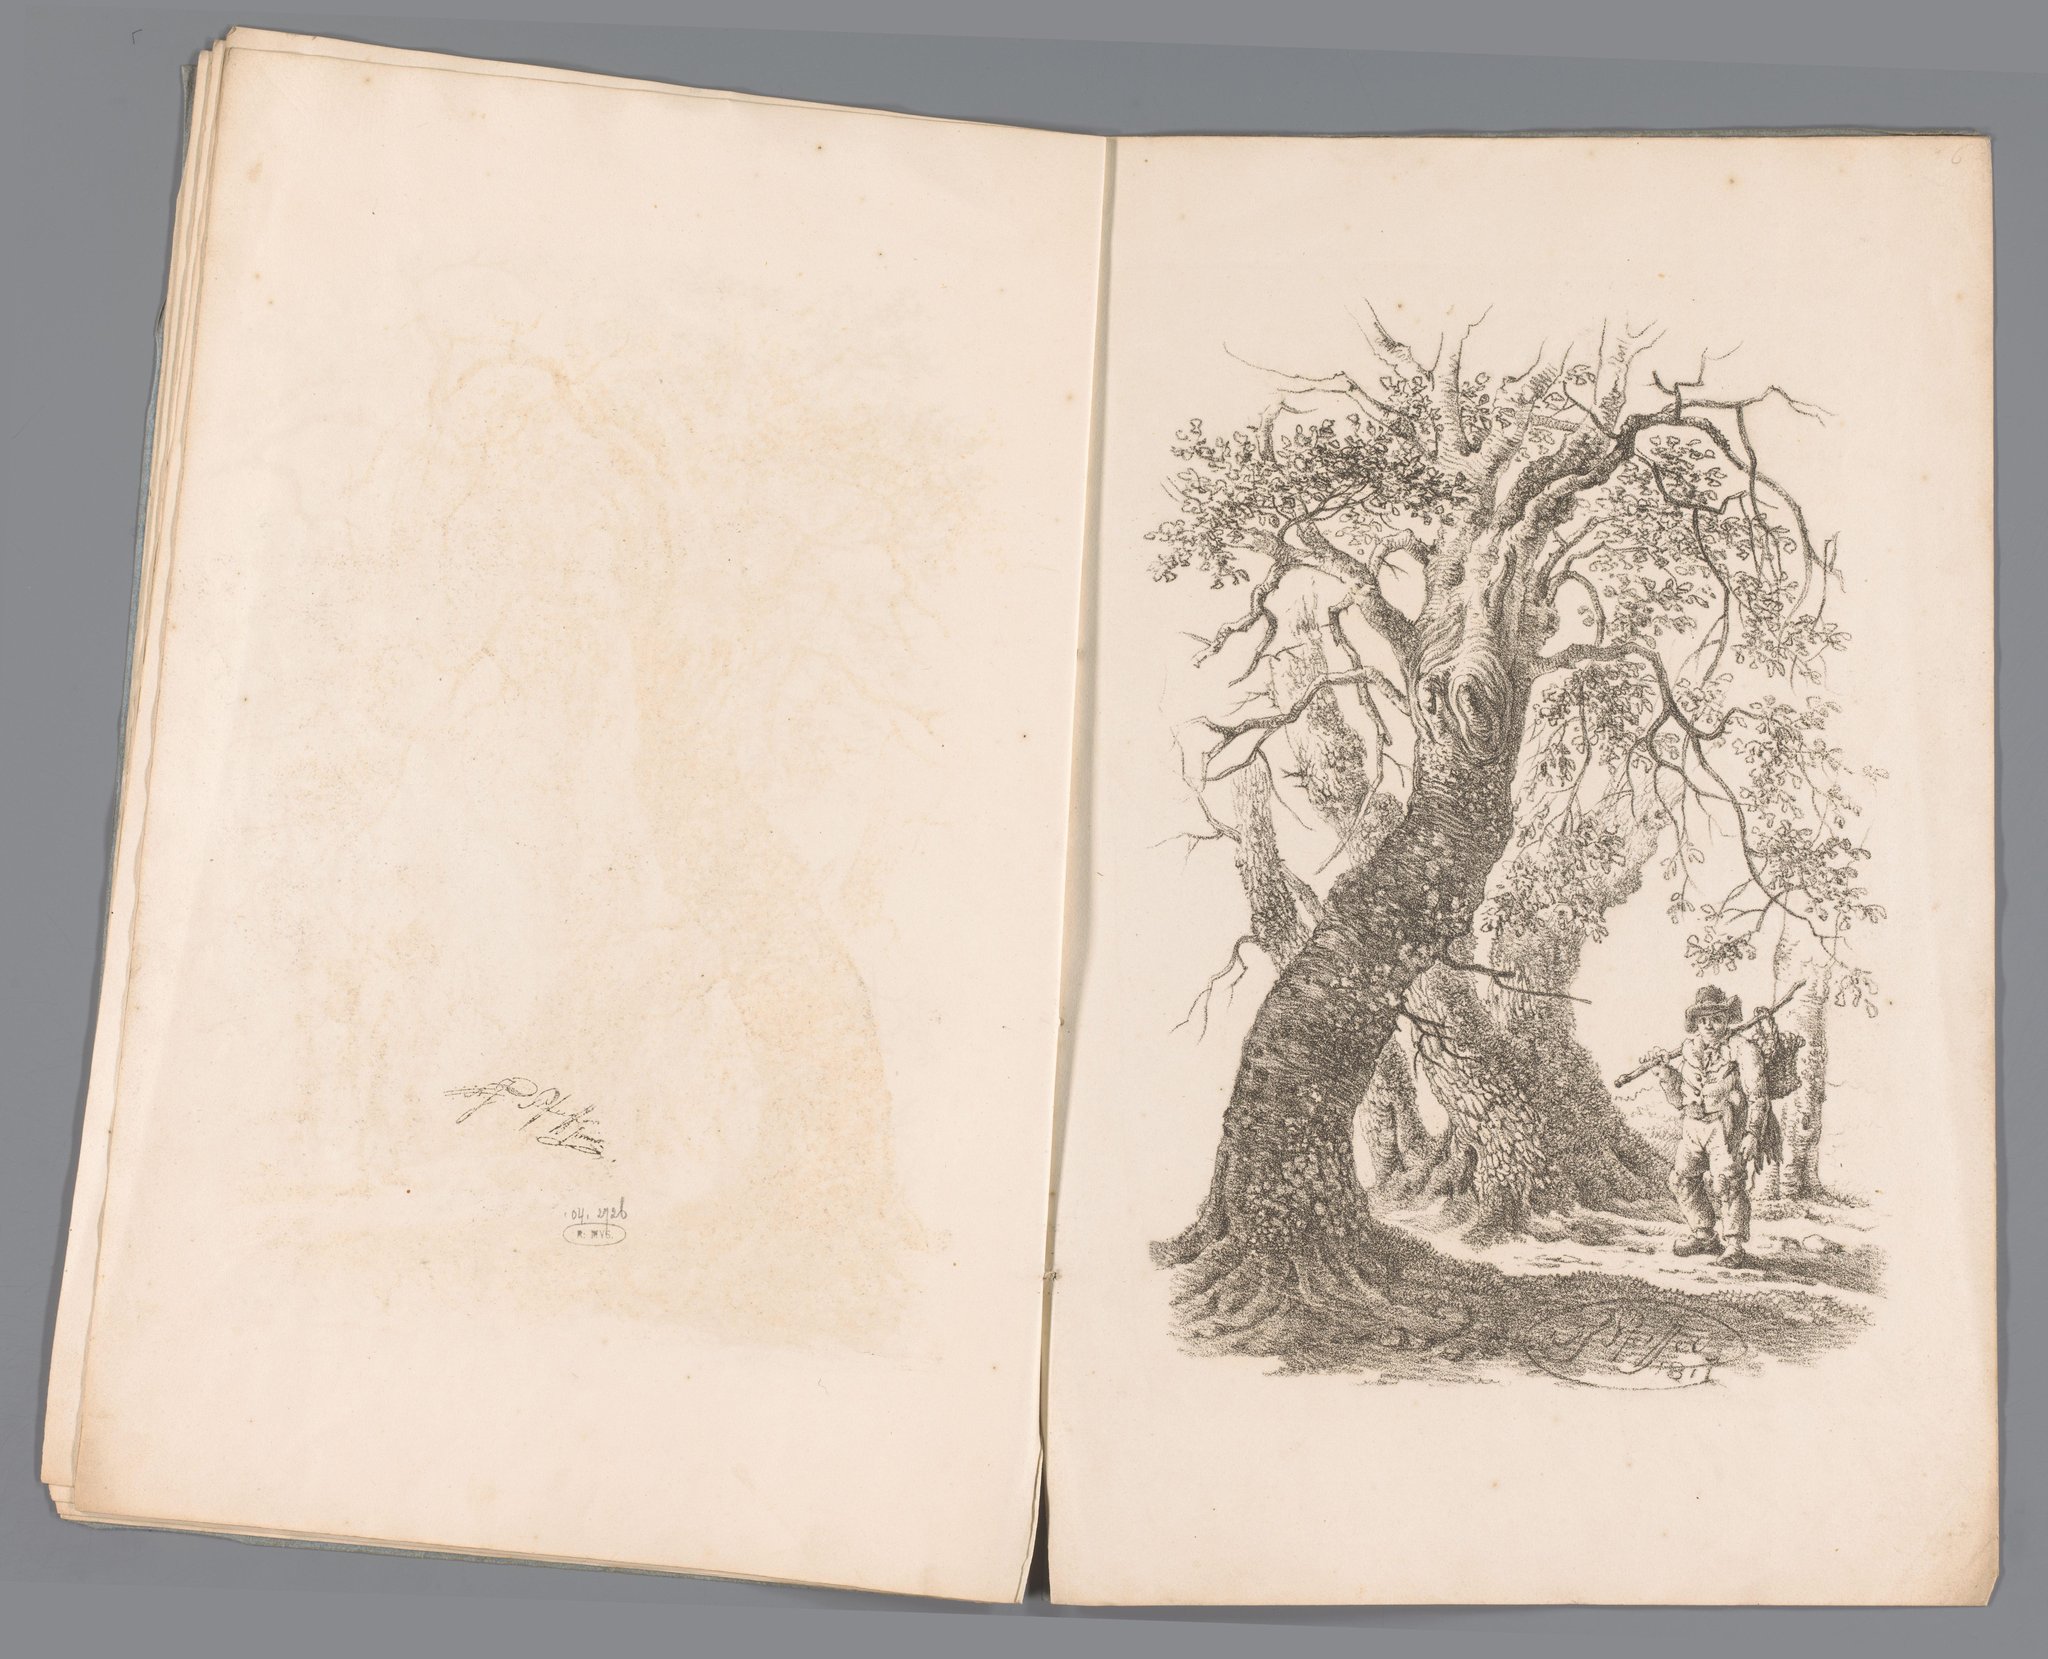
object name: print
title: Etudes du Dessins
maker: françois joseph pfeiffer (ii)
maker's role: draughtsman, print maker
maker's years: 1778-1835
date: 1817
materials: paper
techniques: lithograph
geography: amsterdam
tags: forest, wood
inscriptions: collector's mark: Lugt 2228, signature: ‘F.P. Pfeiffer junior’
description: Naast een boom staat een man met lange stok waaraan een mand hangt. Maakt deel uit van een prentalbum met een serie van zes boomstudies.